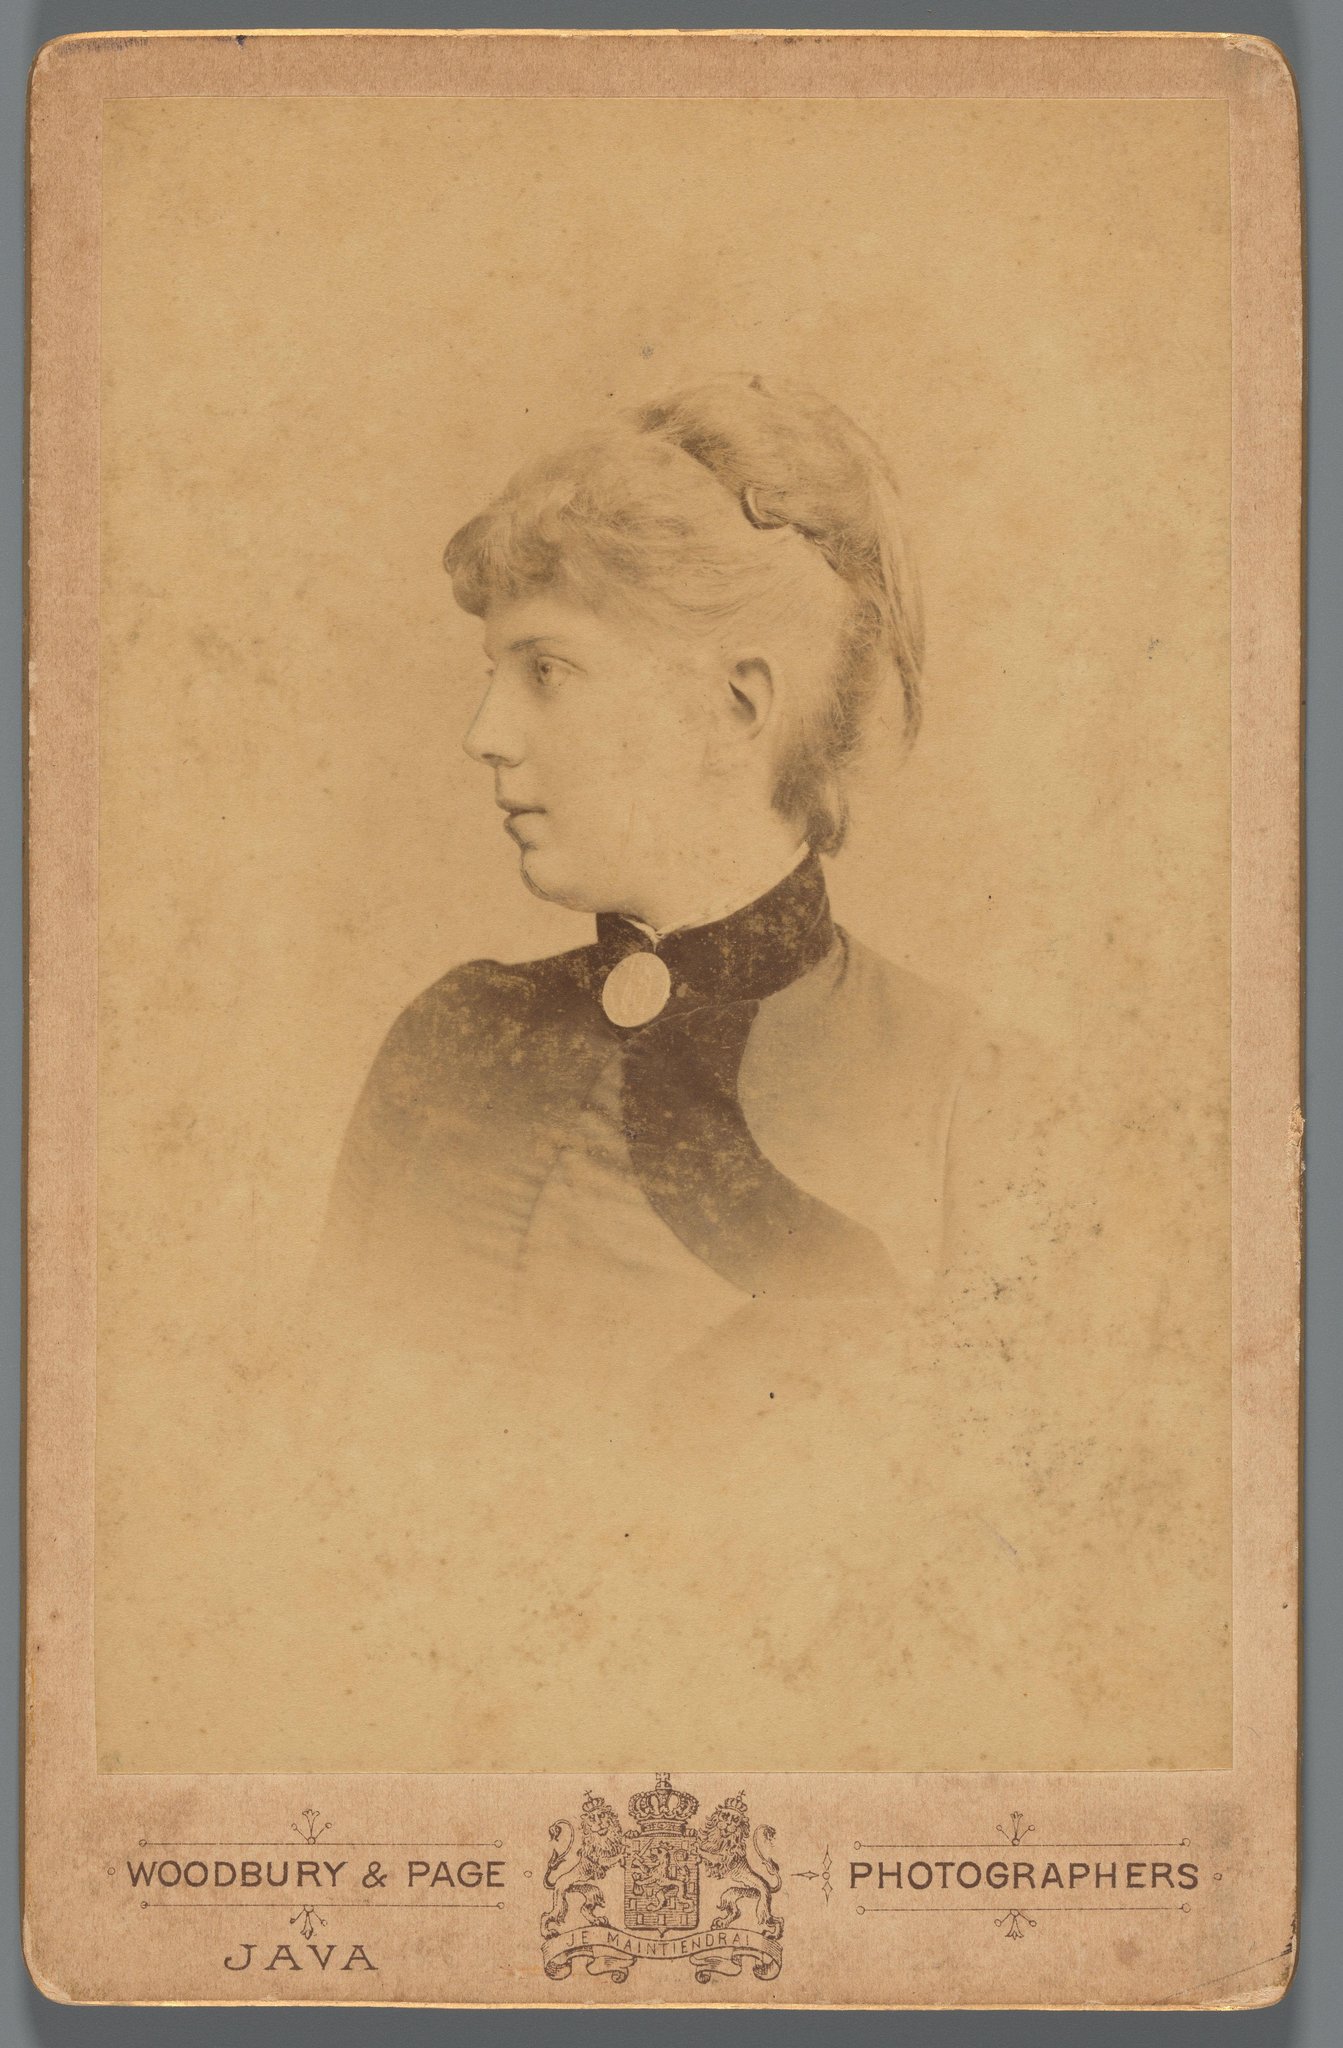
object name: cabinet photograph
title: Studioportret van Pauline van den Berg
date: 1870-1900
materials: cardboard, photographic support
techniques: albumen print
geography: java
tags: batavia, the hague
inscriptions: name: ‘WOODBURY & PAGE PHOTOGRAPHERS / JAVA’, name: ‘WOODBURY & PAGE / PHOTOGRAPHERS / JAVA.’, name: ‘P. v. d Berg’